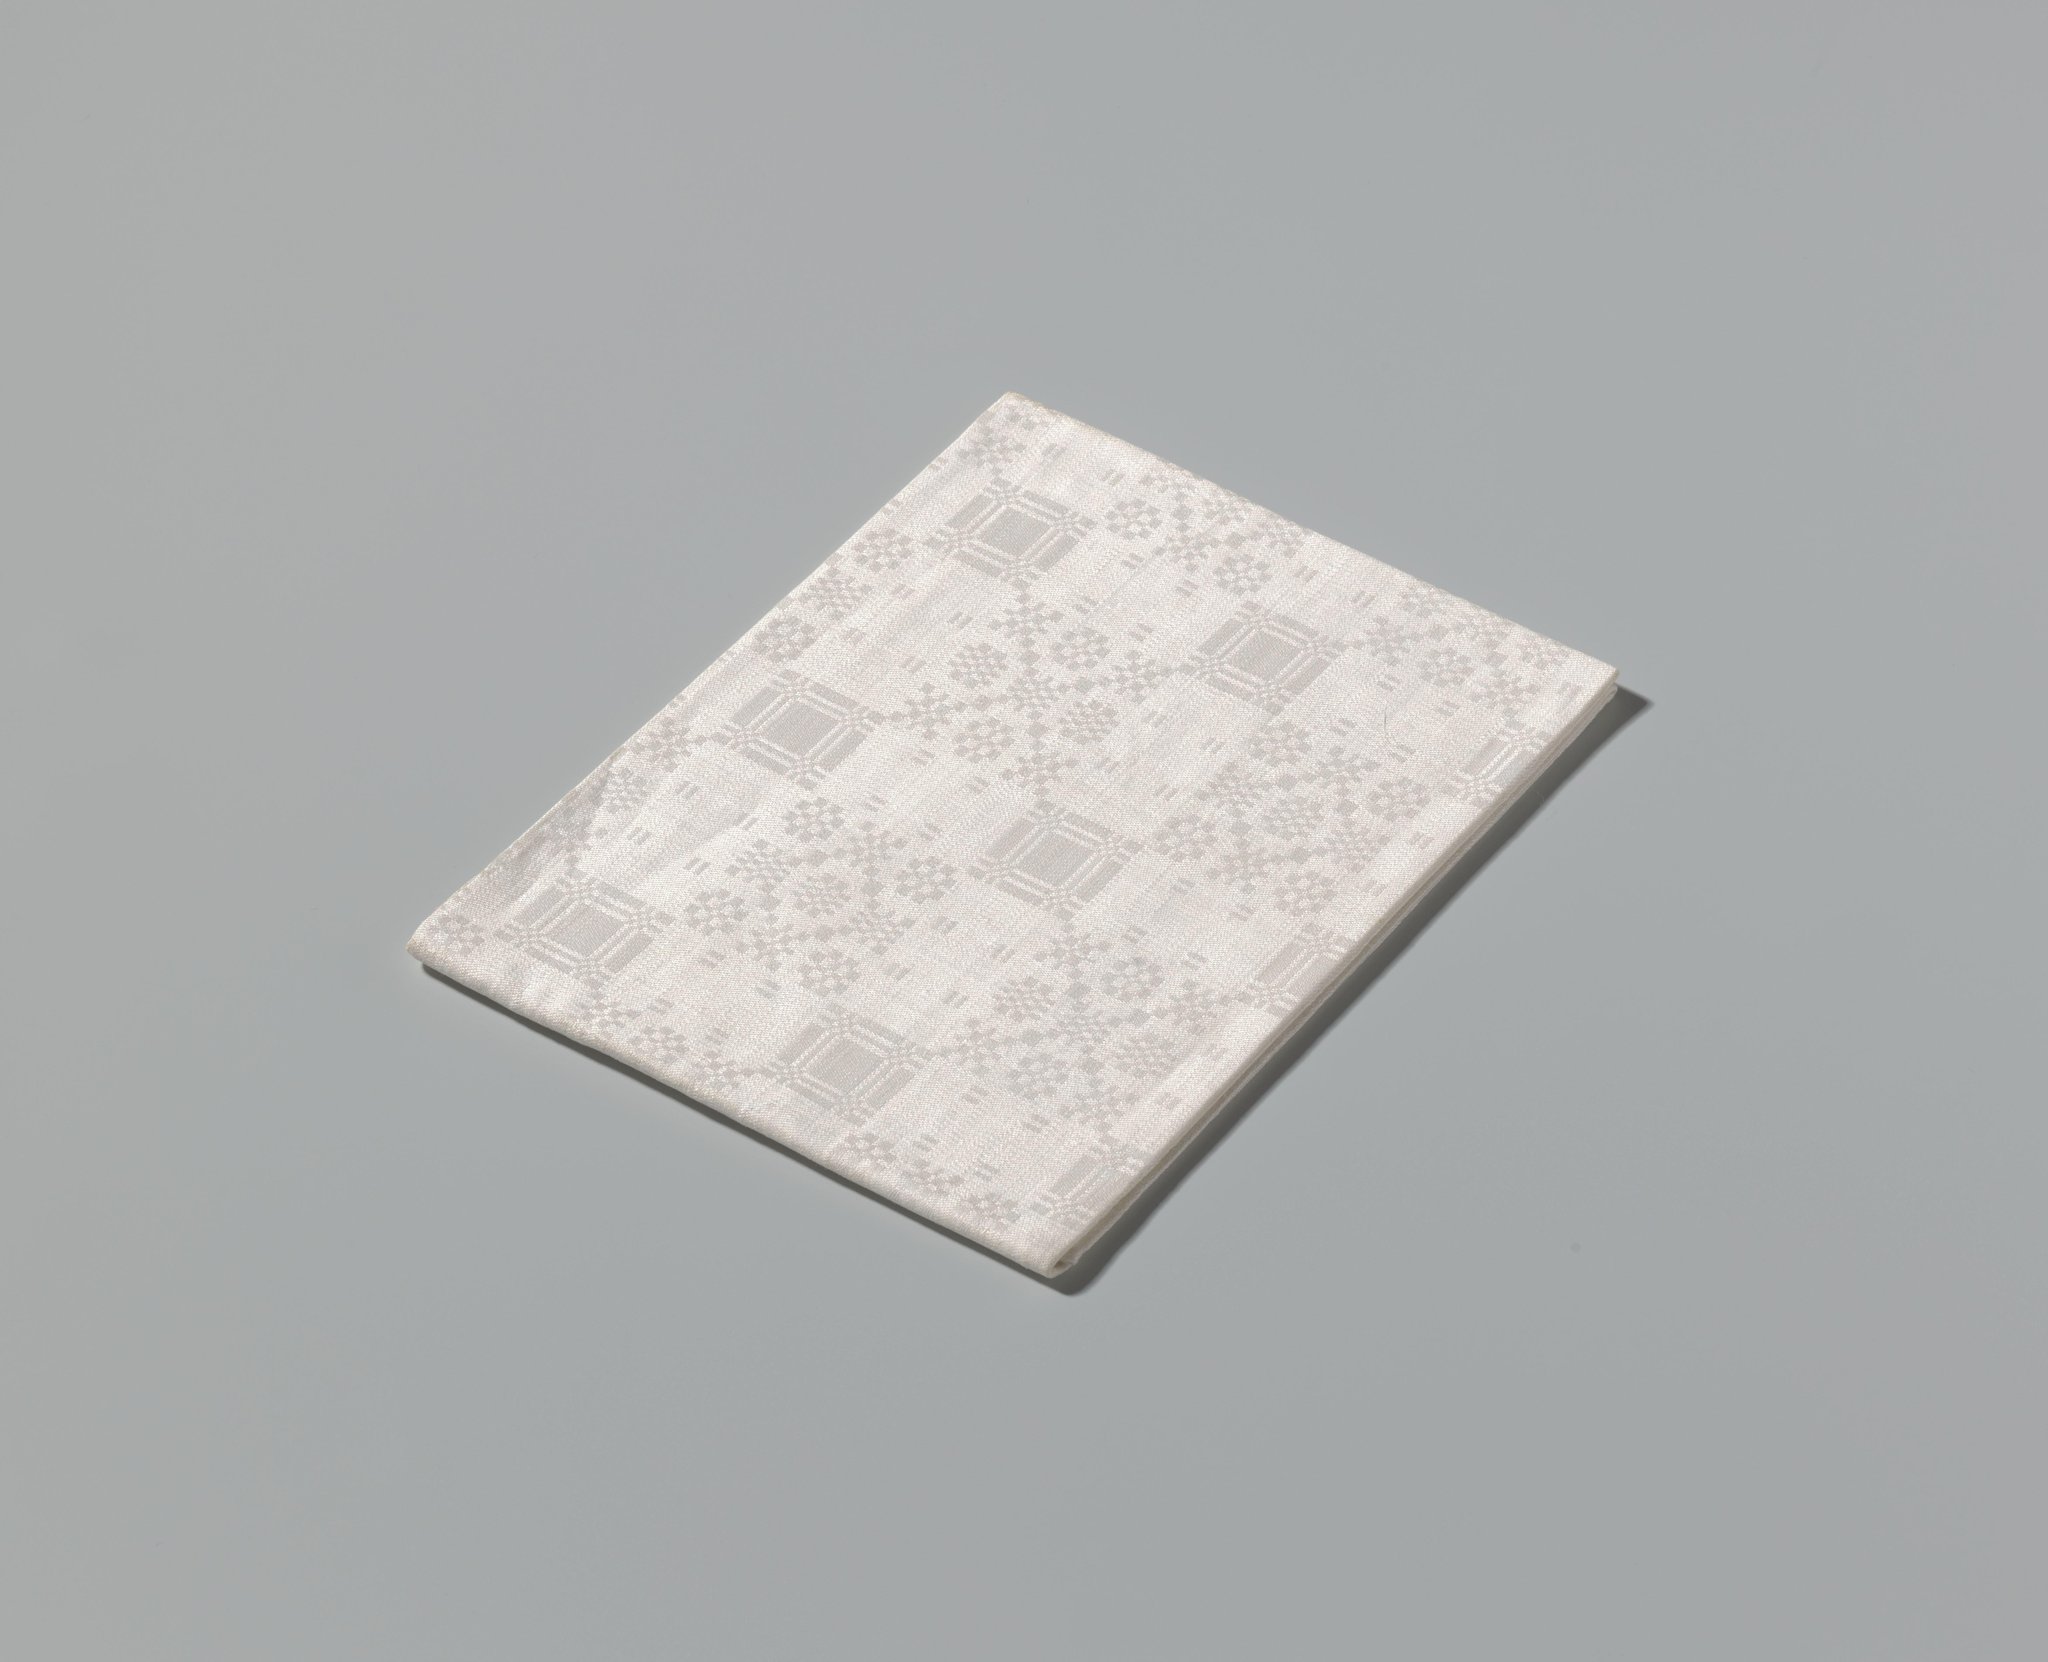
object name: napkin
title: Pellen. Merk: kroon H41 V WH 2oonl.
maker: Anonymous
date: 1700-1850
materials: linen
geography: netherlands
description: Servet van wit linnen met een pellen patroon, merk kroon H 41 en V WH 2oonl.